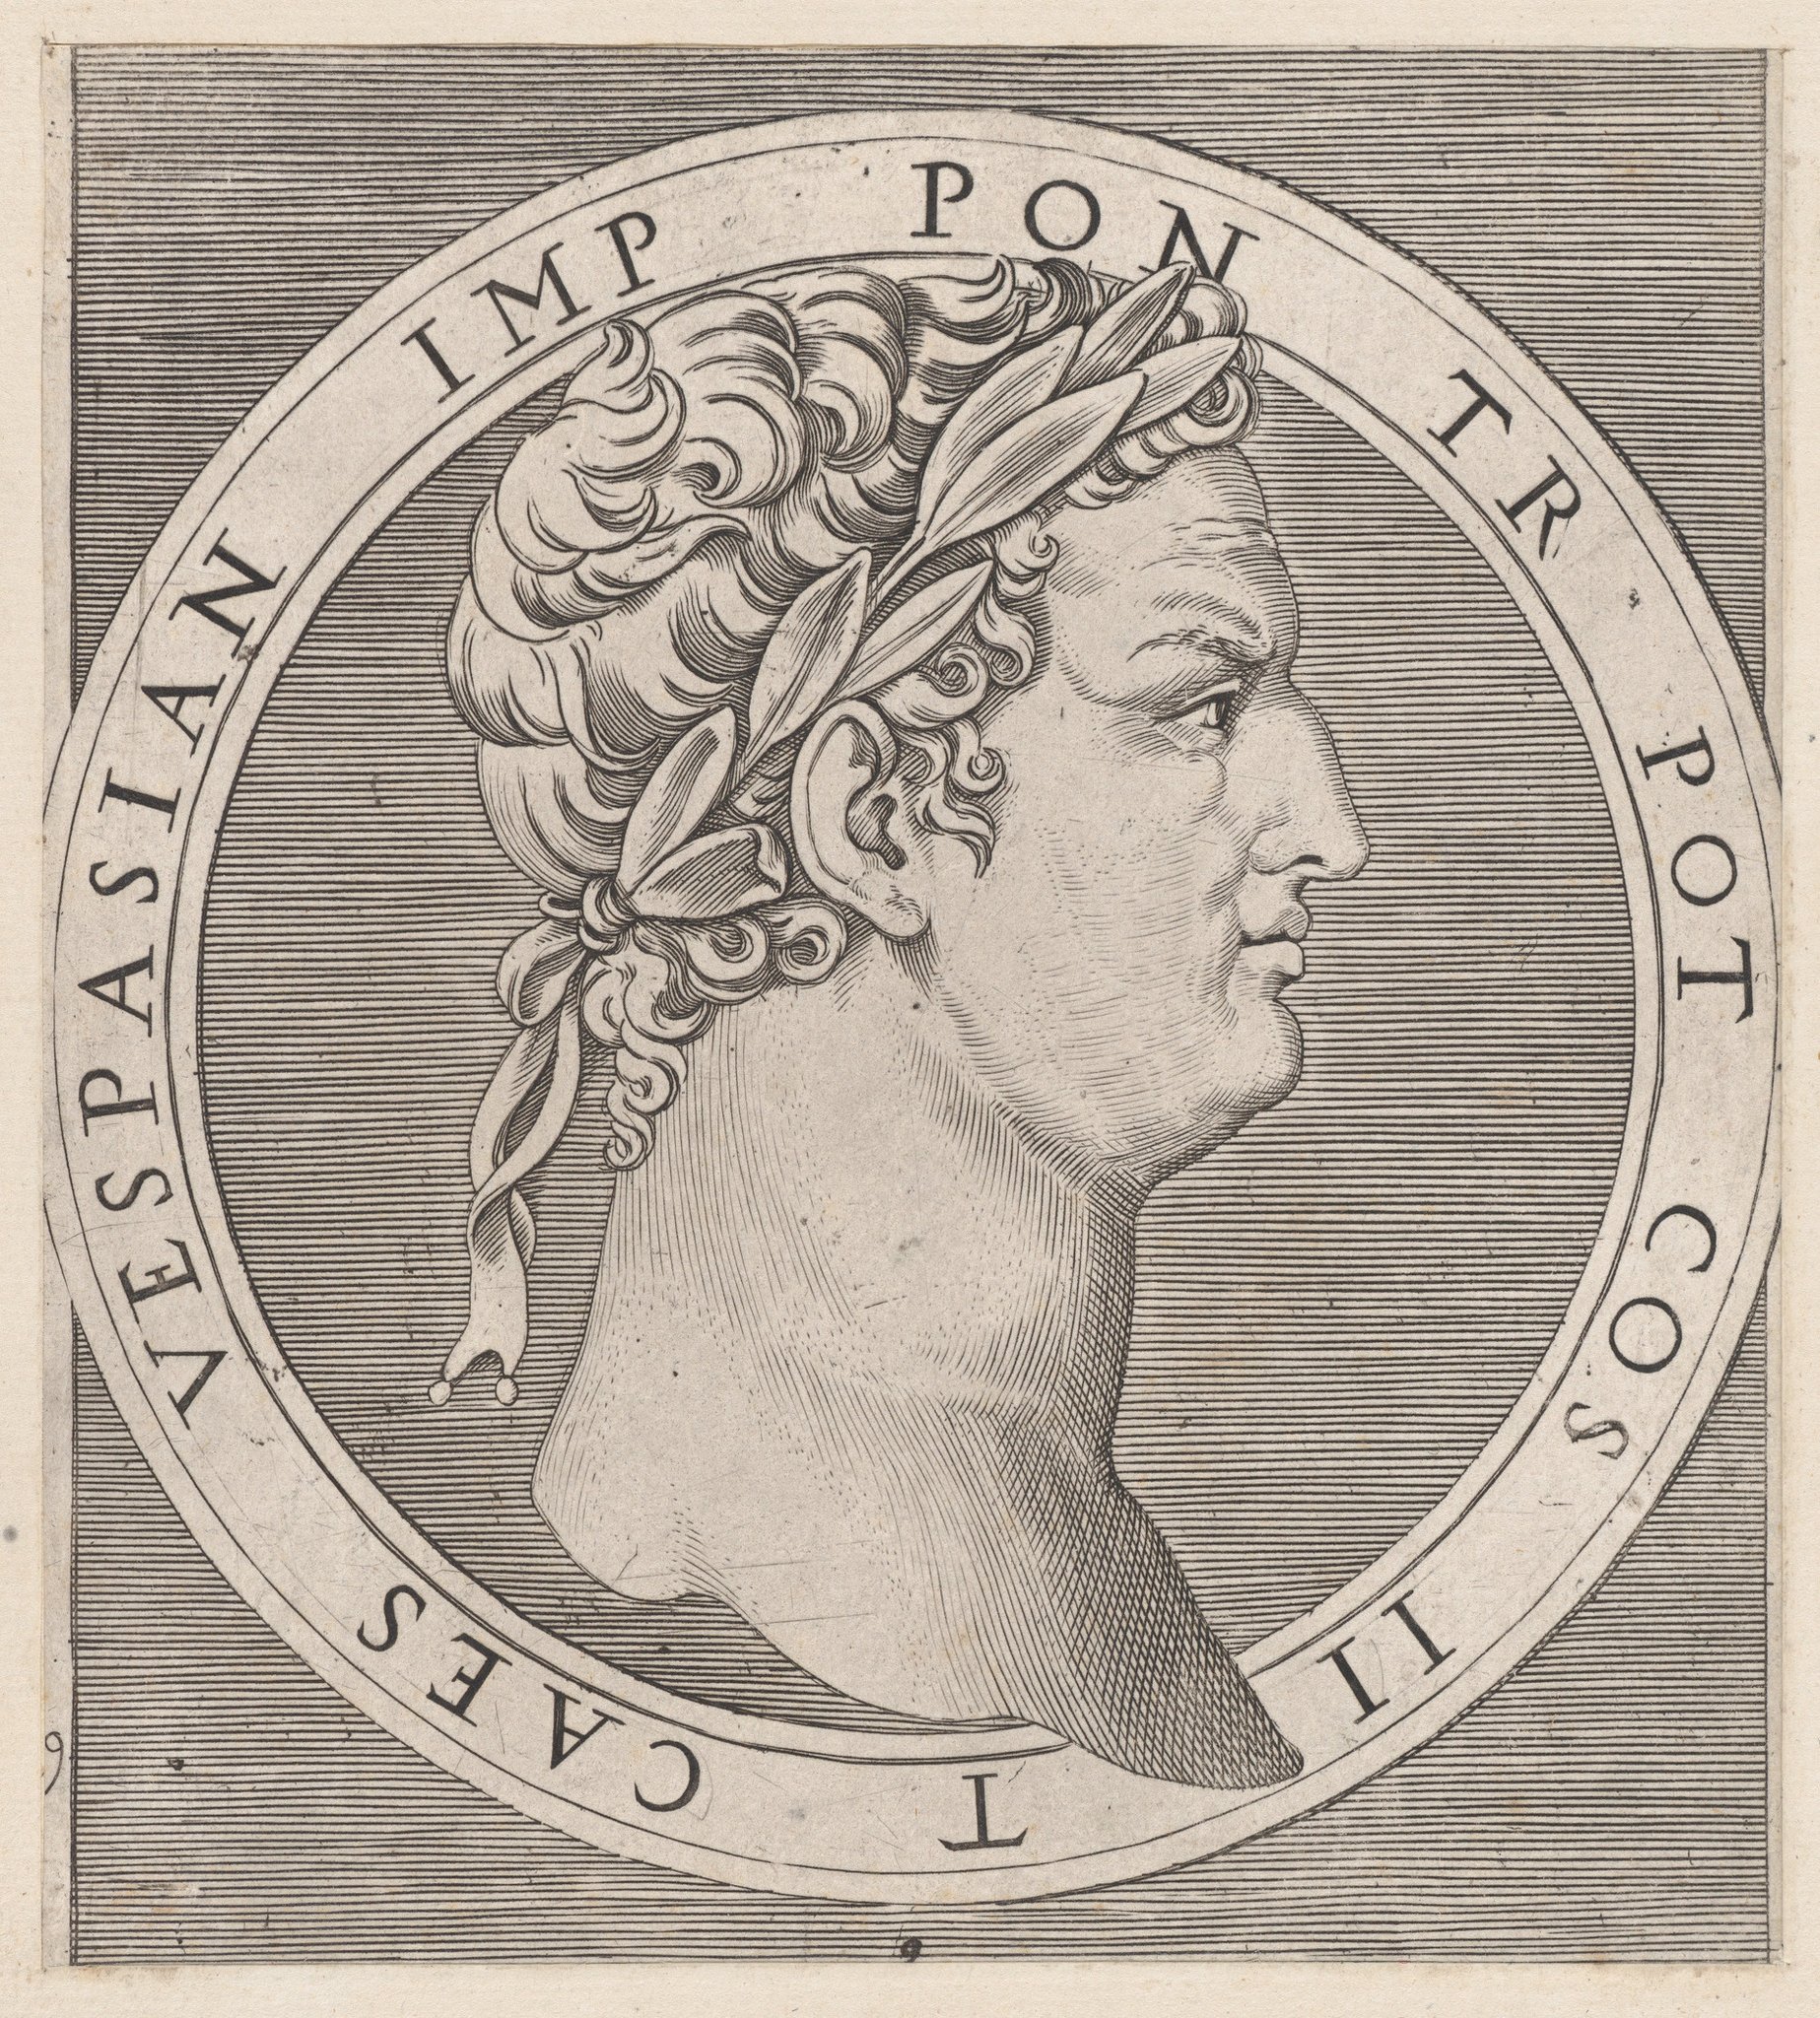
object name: print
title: Vespasian, from The Twelve Caesars, from "Speculum Romanae Magnificentiae"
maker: marcantonio raimondi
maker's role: artist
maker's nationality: italian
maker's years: 1475-1534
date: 1500-1534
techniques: engraving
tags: men,profiles